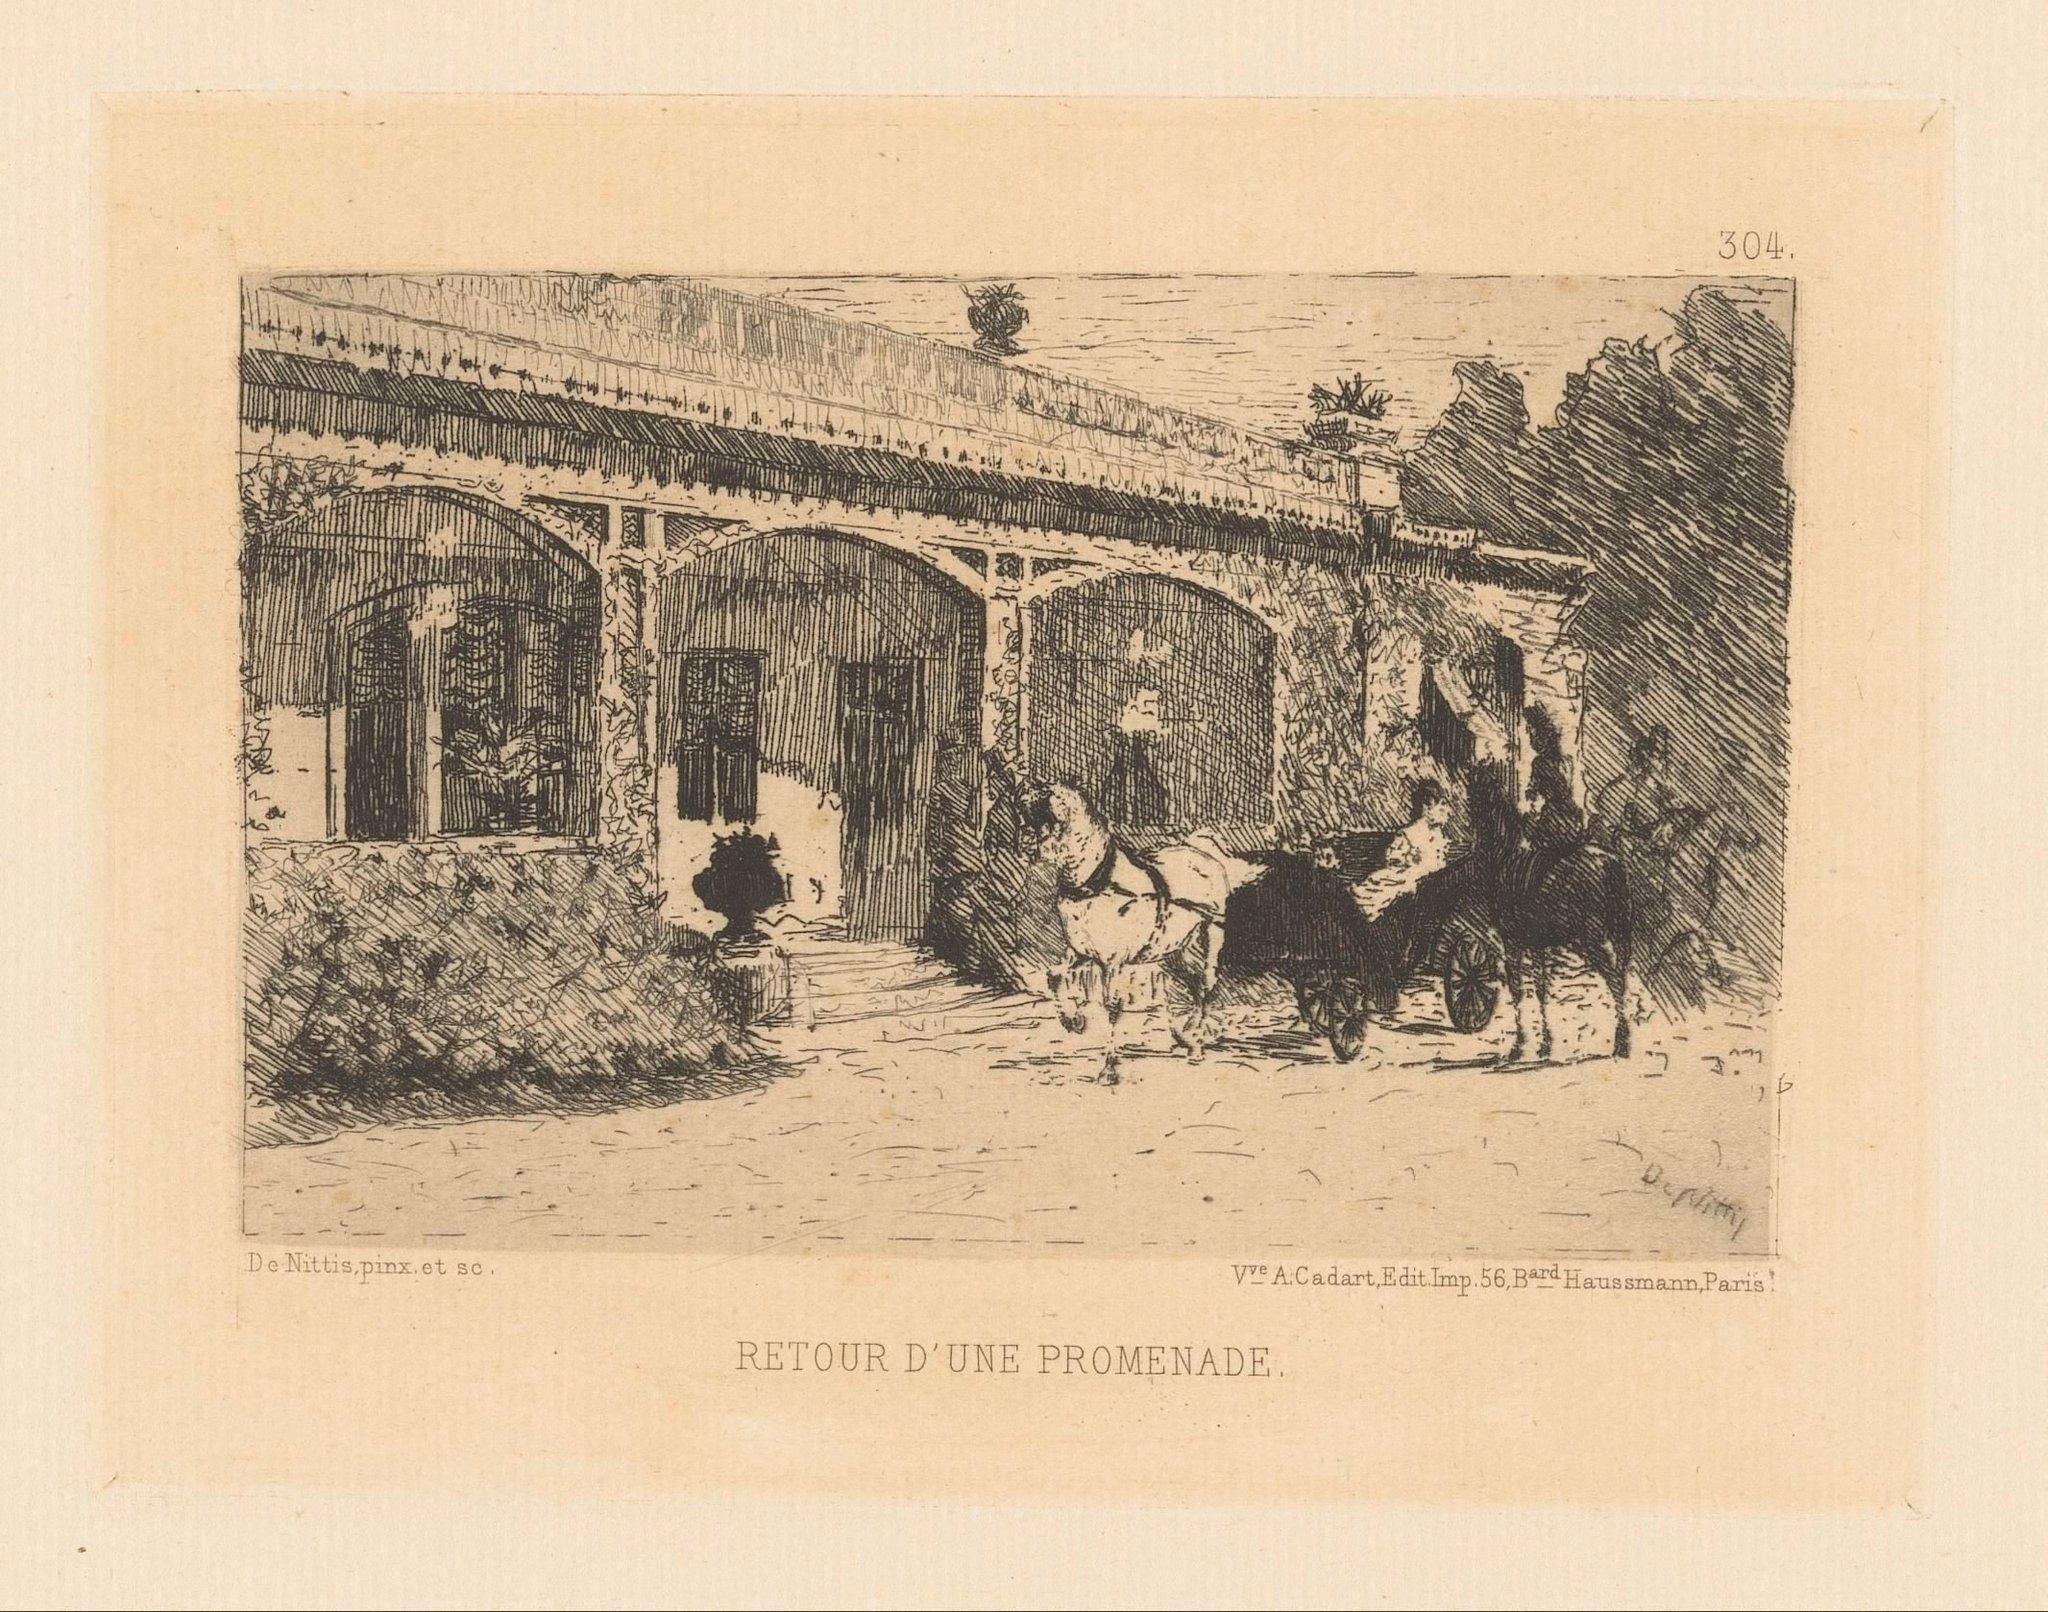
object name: print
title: Nieuwe afbeeldingen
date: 1875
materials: paper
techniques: etching, intaglio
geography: paris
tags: four-wheeled vehicle drawn by one animal, strolling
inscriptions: collector's mark: Lugt 2233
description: Prent naar het schilderij 'Caffè a Parigi' van Giuseppe de Nittis in het Museo di Capodimonte te Napels. Prent uit de serie 'L'illustration Nouvelle', uitgegeven door Alfred Cadart te Parijs in 1875.